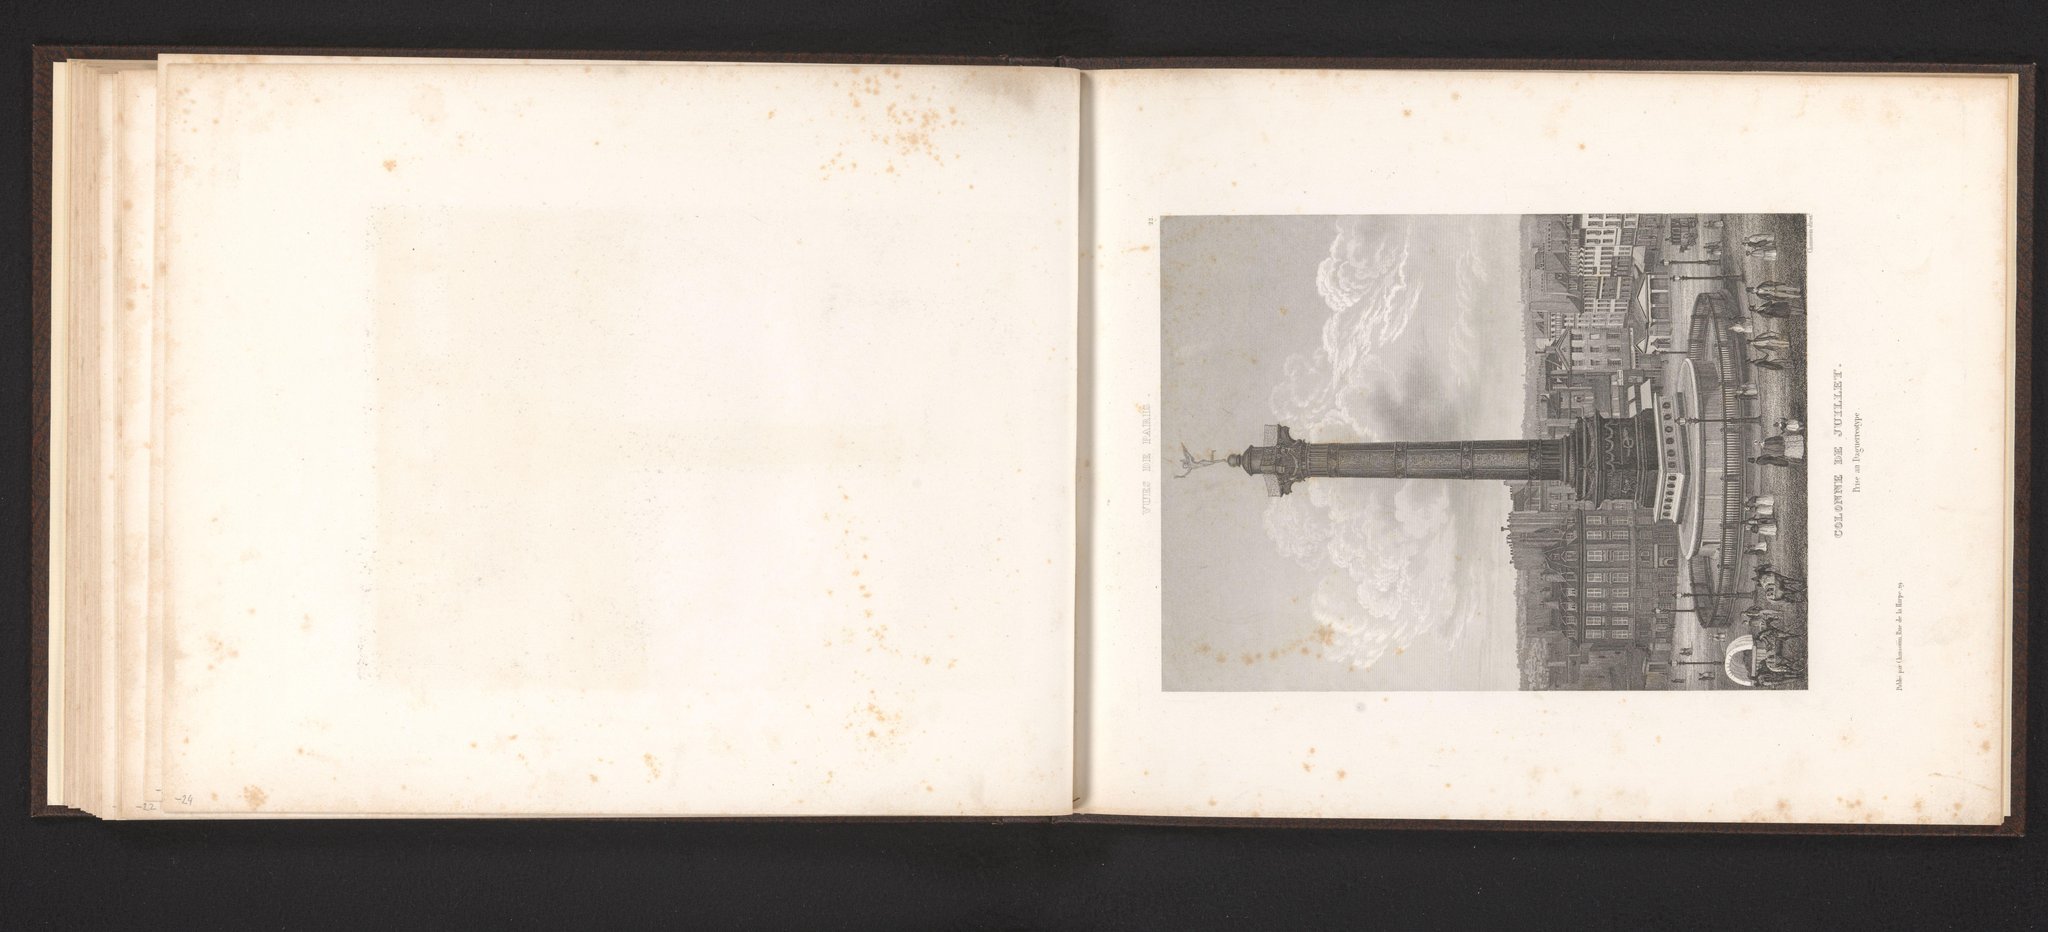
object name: page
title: Gezicht op de colonne de Juillet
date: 1845-1850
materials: paper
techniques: engraving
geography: paris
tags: square, place, circus, etc., obelisk, needle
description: Prent op vijfentwintigste ongenummerde pagina na titelpagina. Prent gemaakt naar daguerreotypie.